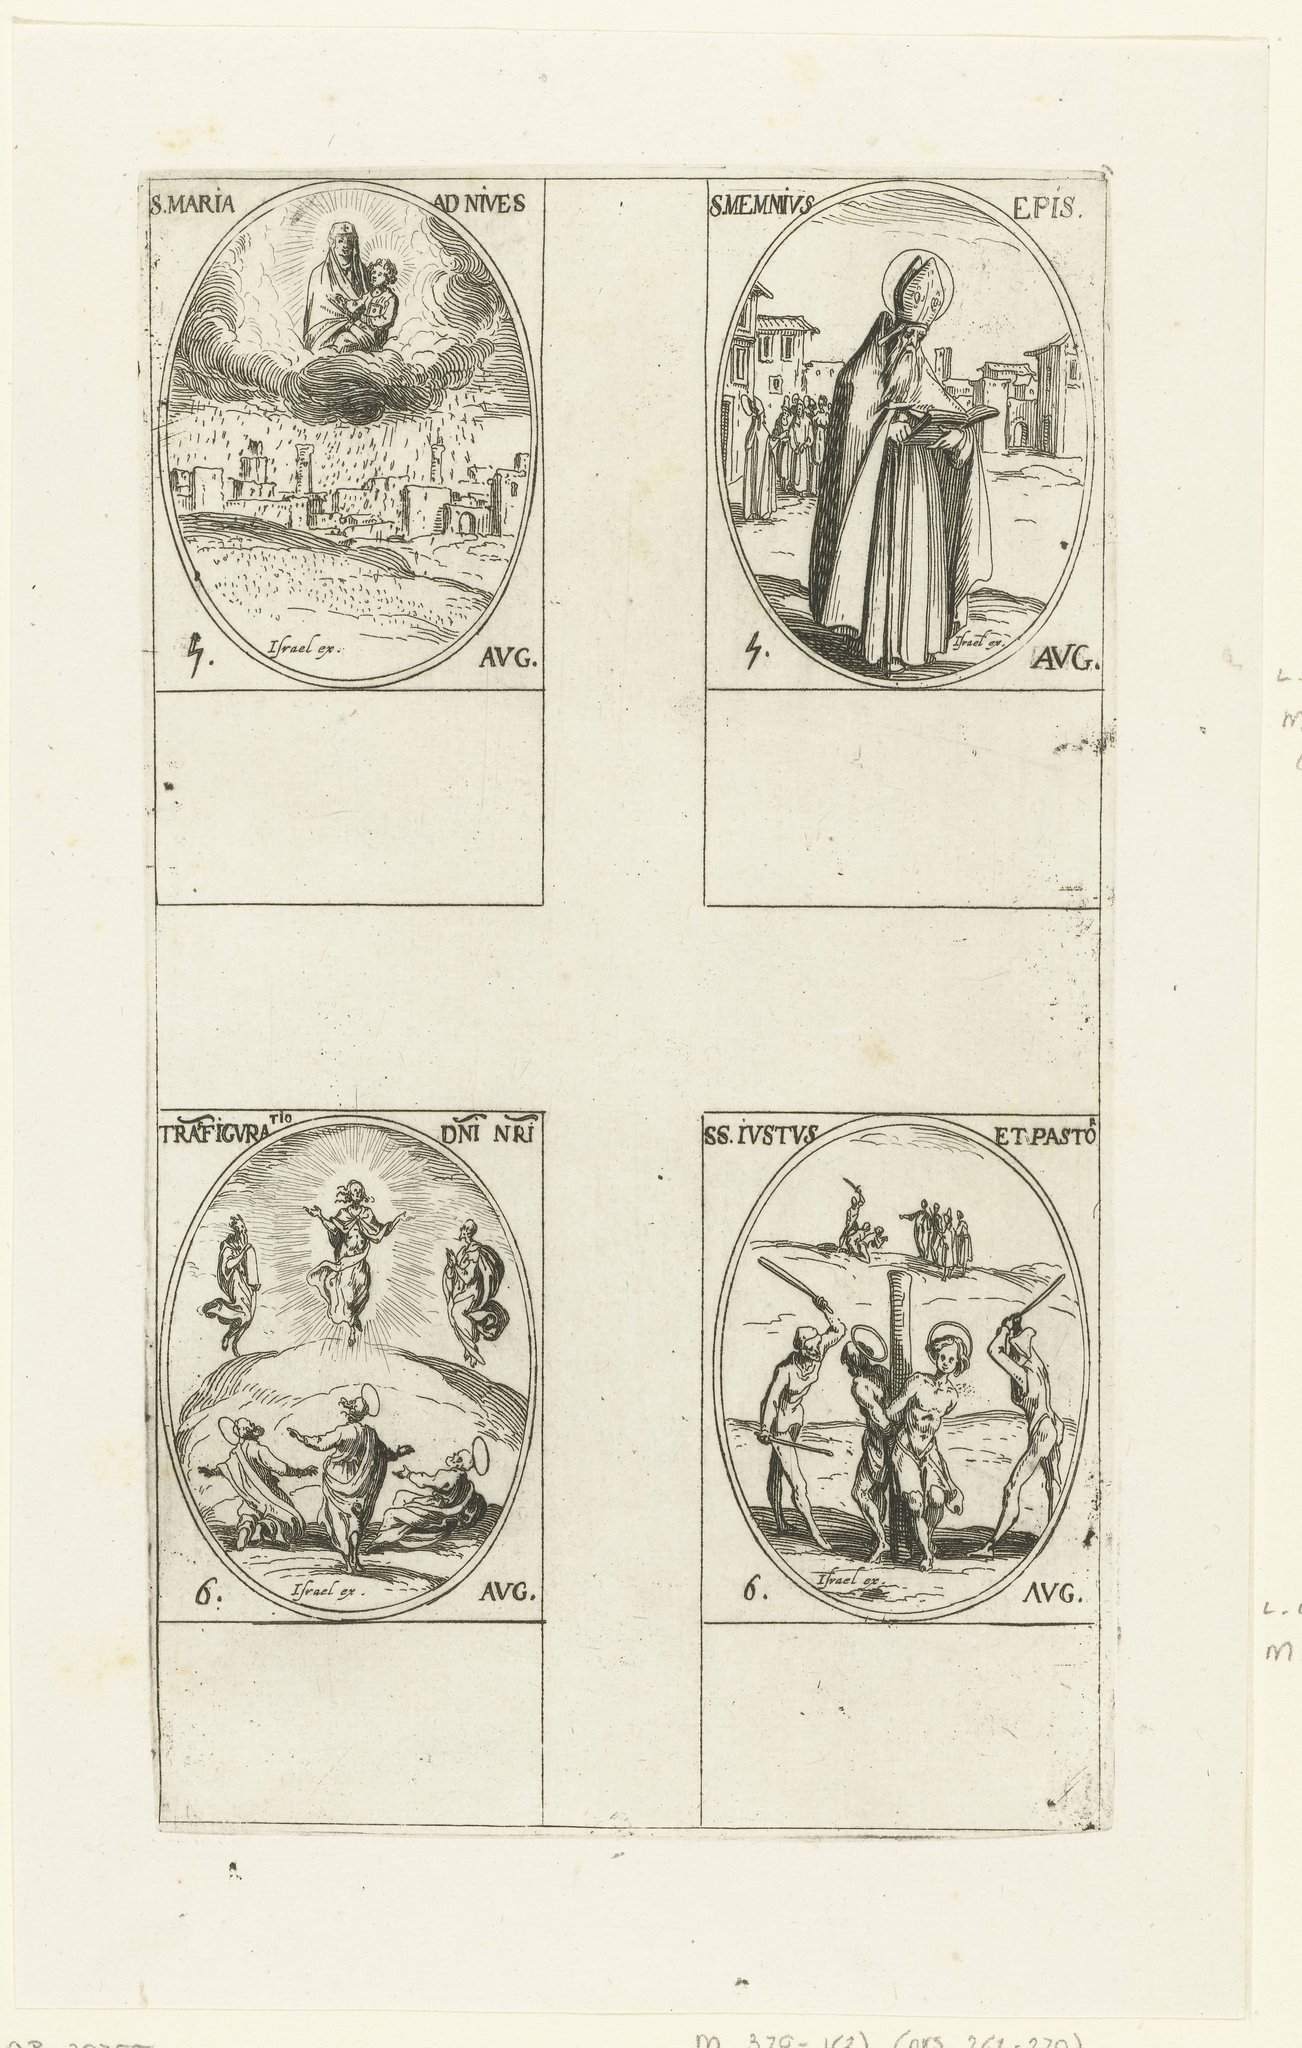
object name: print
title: Alle heiligen en de Christelijke feestdagen van het jaar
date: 1632-1636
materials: paper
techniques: etching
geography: paris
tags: the transfiguration: moses and elijah appear on either side of christ on mount tabor (matthew 17:1-13; mark 9:2-13; luke 9:28-36), male saints (with name), miraculous indication of the building-site of santa maria maggiore in the snow (by the virgin mary)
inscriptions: collector's mark: Lugt 240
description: Blad met vier ovale voorstellingen, elk met opschrift en datum in het Latijn: linksboven Maria met het Christuskind in een wolk waaruit sneeuw dwarrelt op een stad, rechtsboven de Heilige Memmius gekleed als bisschop, linksonder de gedaanteverandering van Christus op de berg Tabor, rechtsonder de Heilige Justus en de Heilige Pastor die met stokken geslagen worden. Deze prent is onderdeel van een serie prenten met voorstellingen van de heiligen en de christelijke feestdagen van het jaar. Er zijn steeds vier scènes van één plaat op één blad gedrukt. Inclusief bijbehorend titelblad en frontispice gaat het in totaal om 124 platen (490 voorstellingen). De drie platen met de laatste 12 scènes (de veranderlijke christelijke feestdagen) zijn in de derde staat versneden tot 12 kleine plaatjes, en met een apart titelblad uitgegeven.